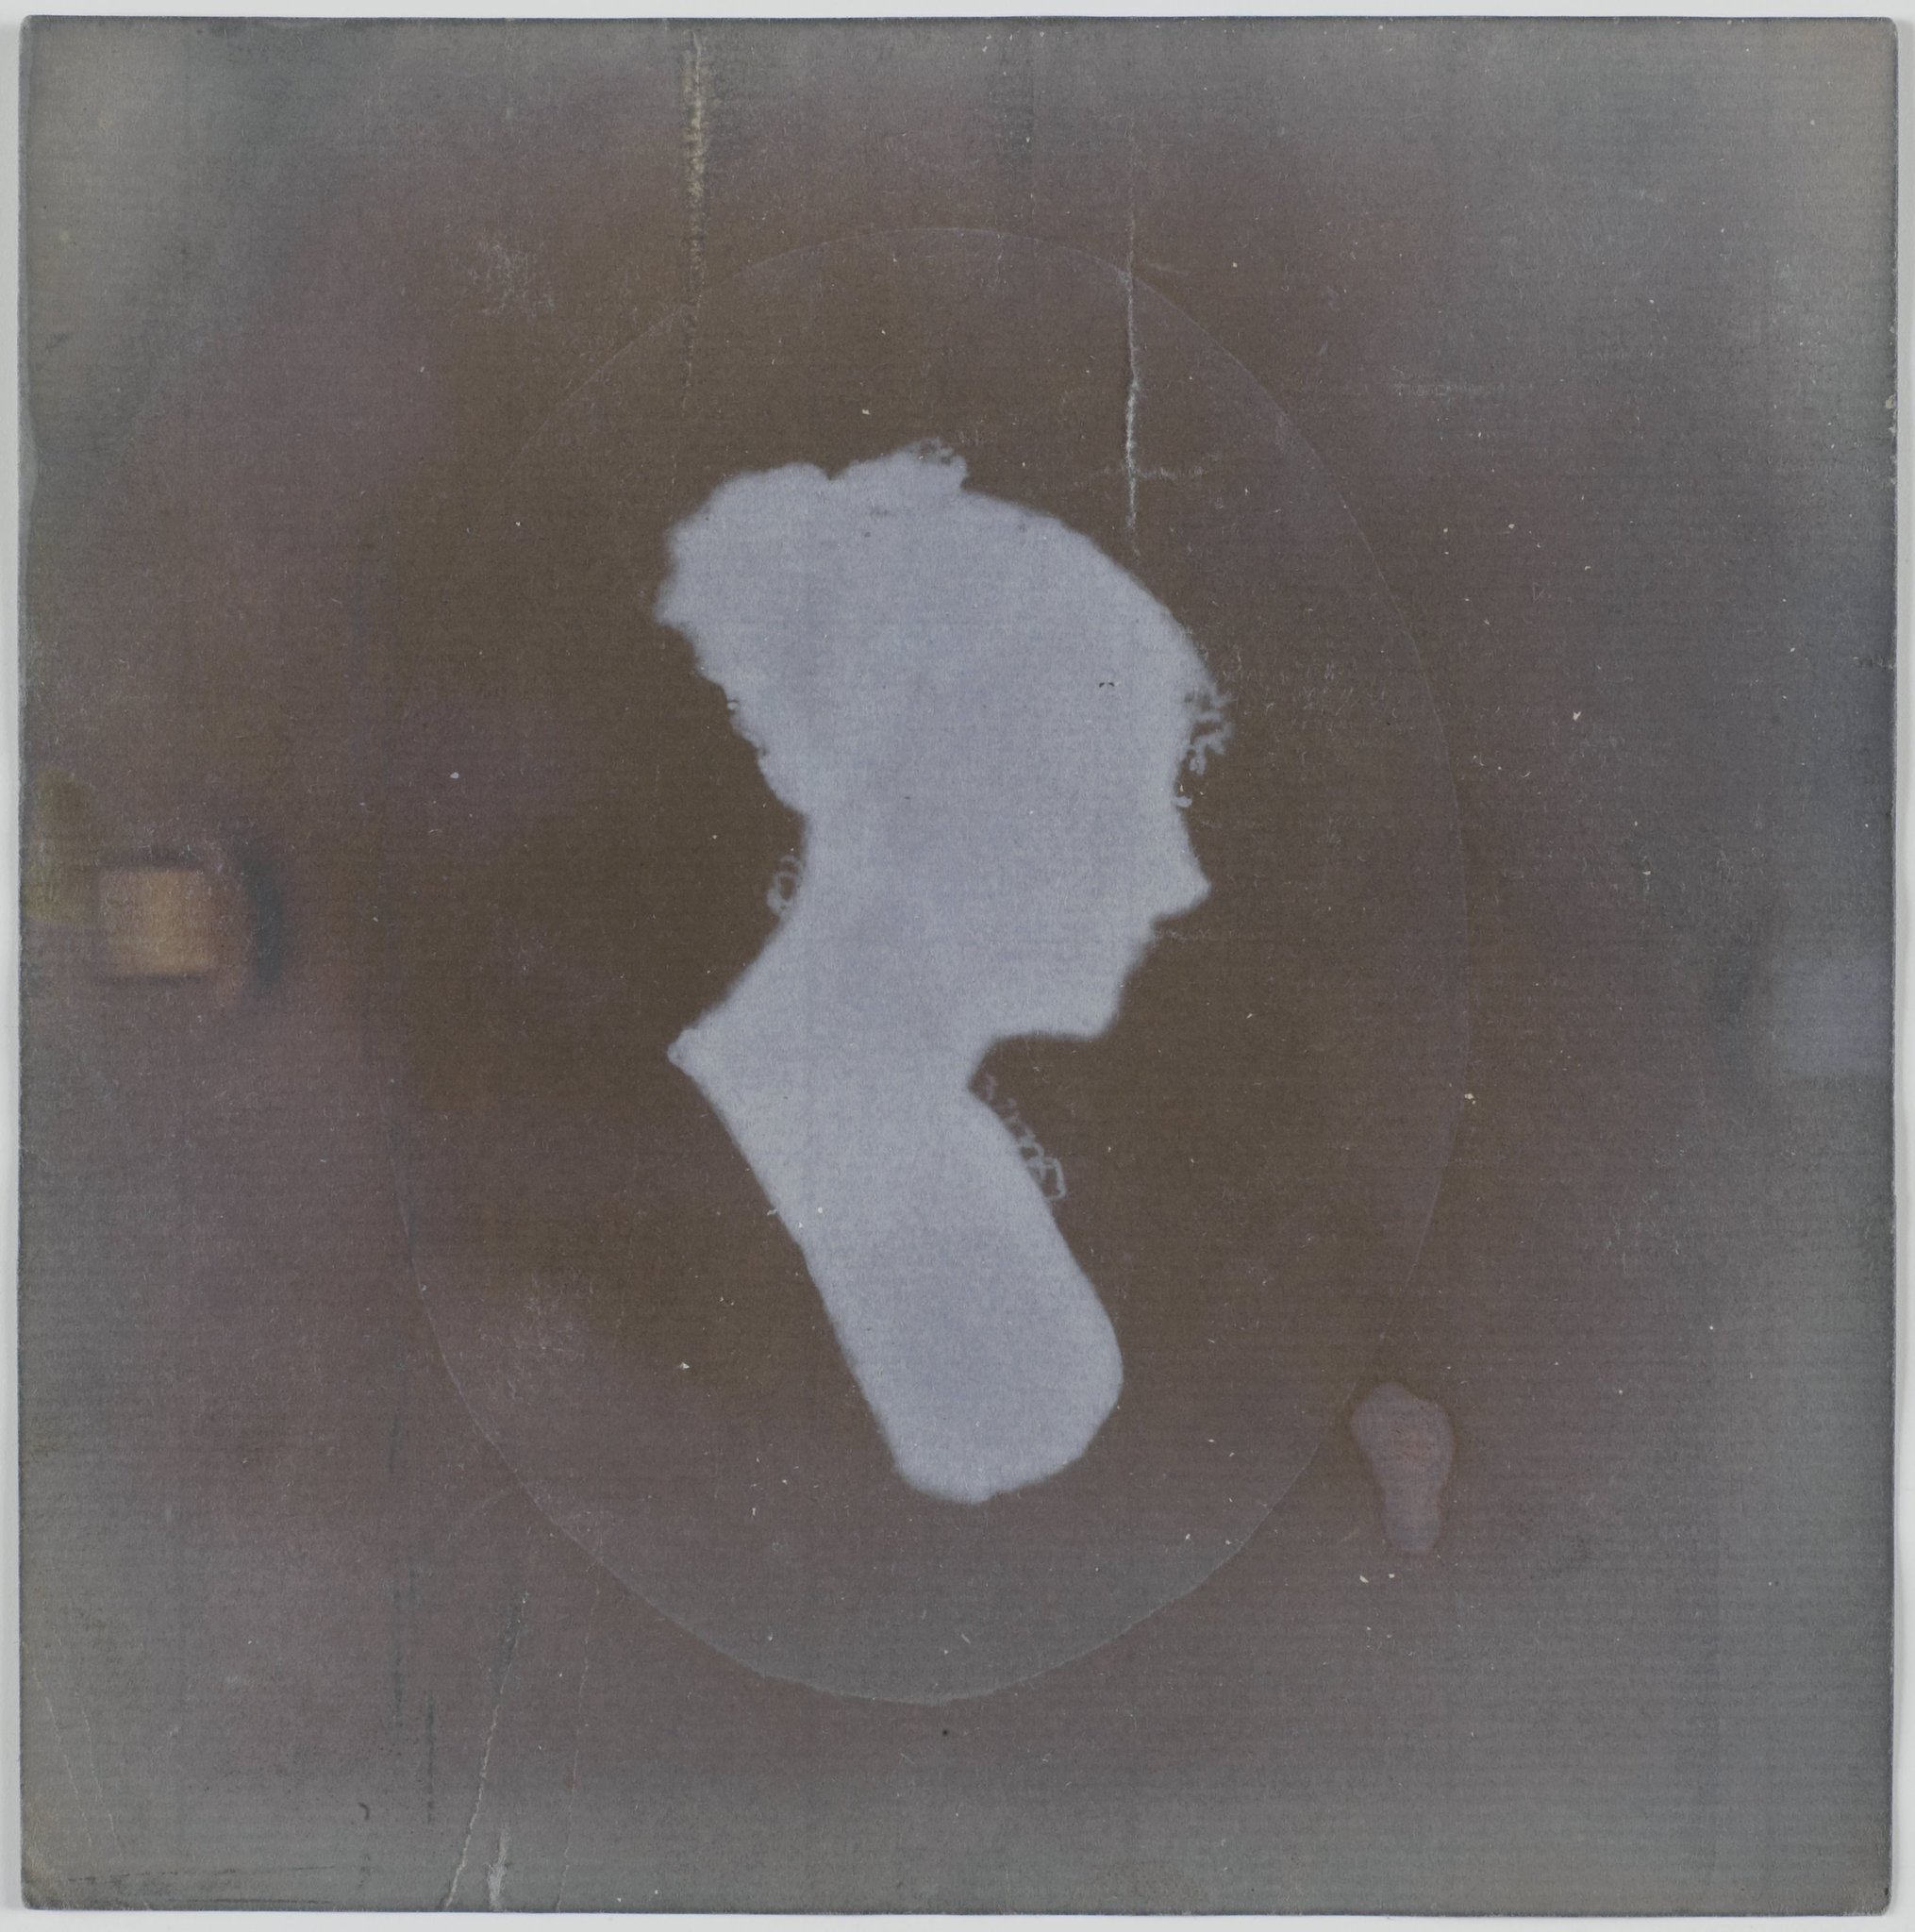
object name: photogram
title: Portret van een vrouw in silhouet vorm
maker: Anonymous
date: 1839-1860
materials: paper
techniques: photogenic drawing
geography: great britain